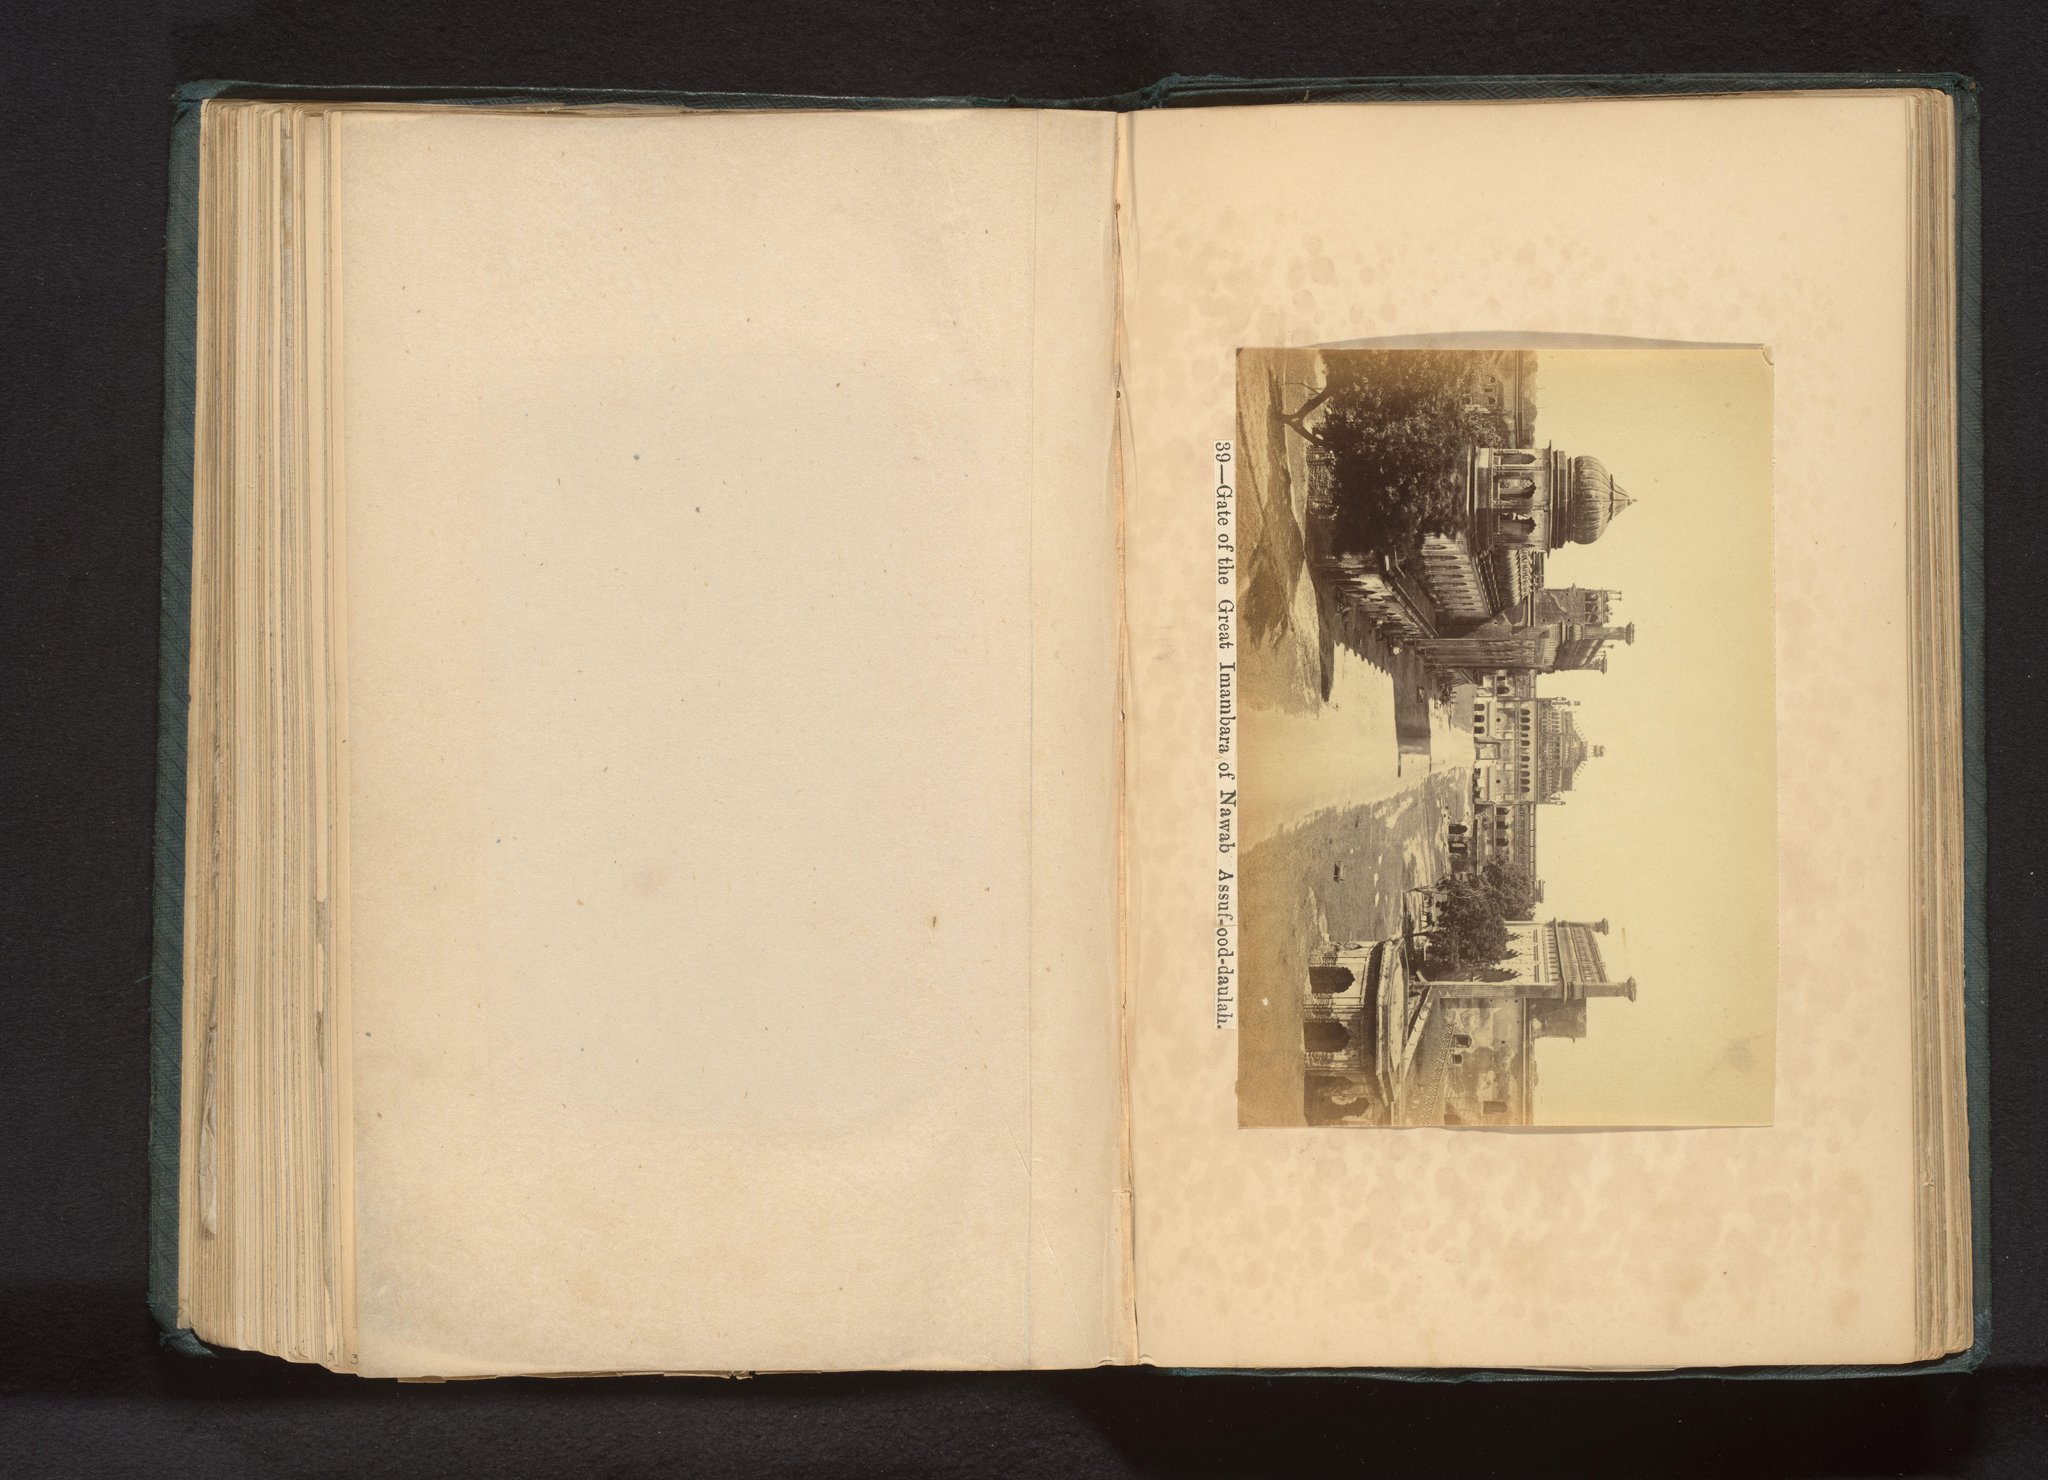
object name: page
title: Gate of the Great Imambara of Nawab Assuf-ood-daulah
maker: darogha ubbas alli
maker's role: fotograaf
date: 1864-1874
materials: photographic support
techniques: albumen print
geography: lucknow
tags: temple, shrine ~ islam, mohammedanism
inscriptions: number: ‘39’